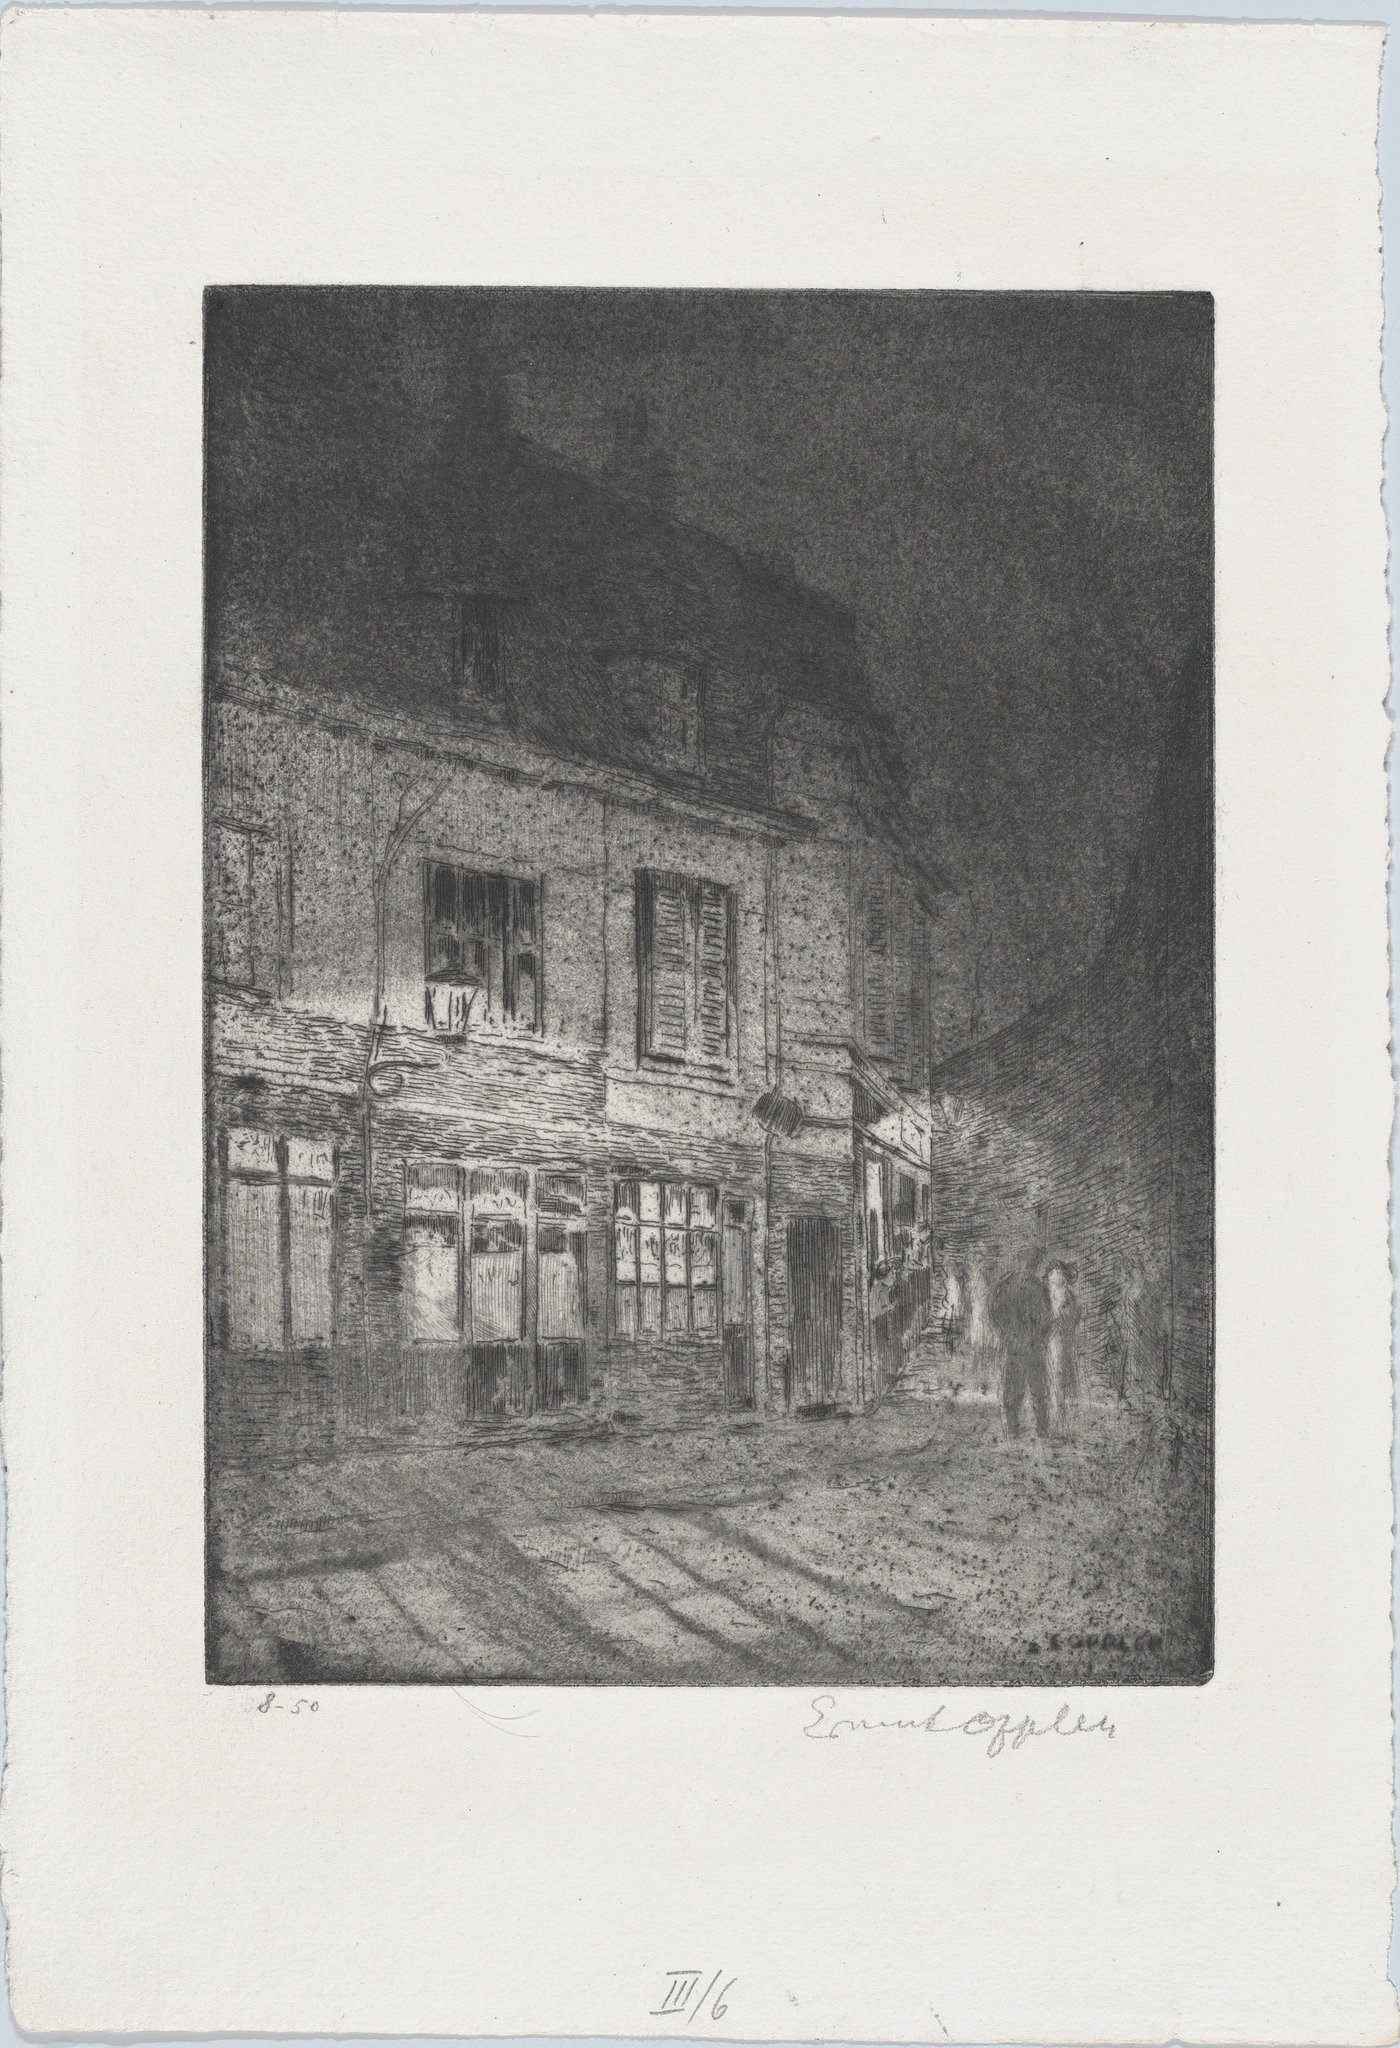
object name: print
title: Lille: Liebesgässchen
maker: ernst oppler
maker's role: artist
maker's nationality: german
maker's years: 1867-1929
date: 1916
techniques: etching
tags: buildings